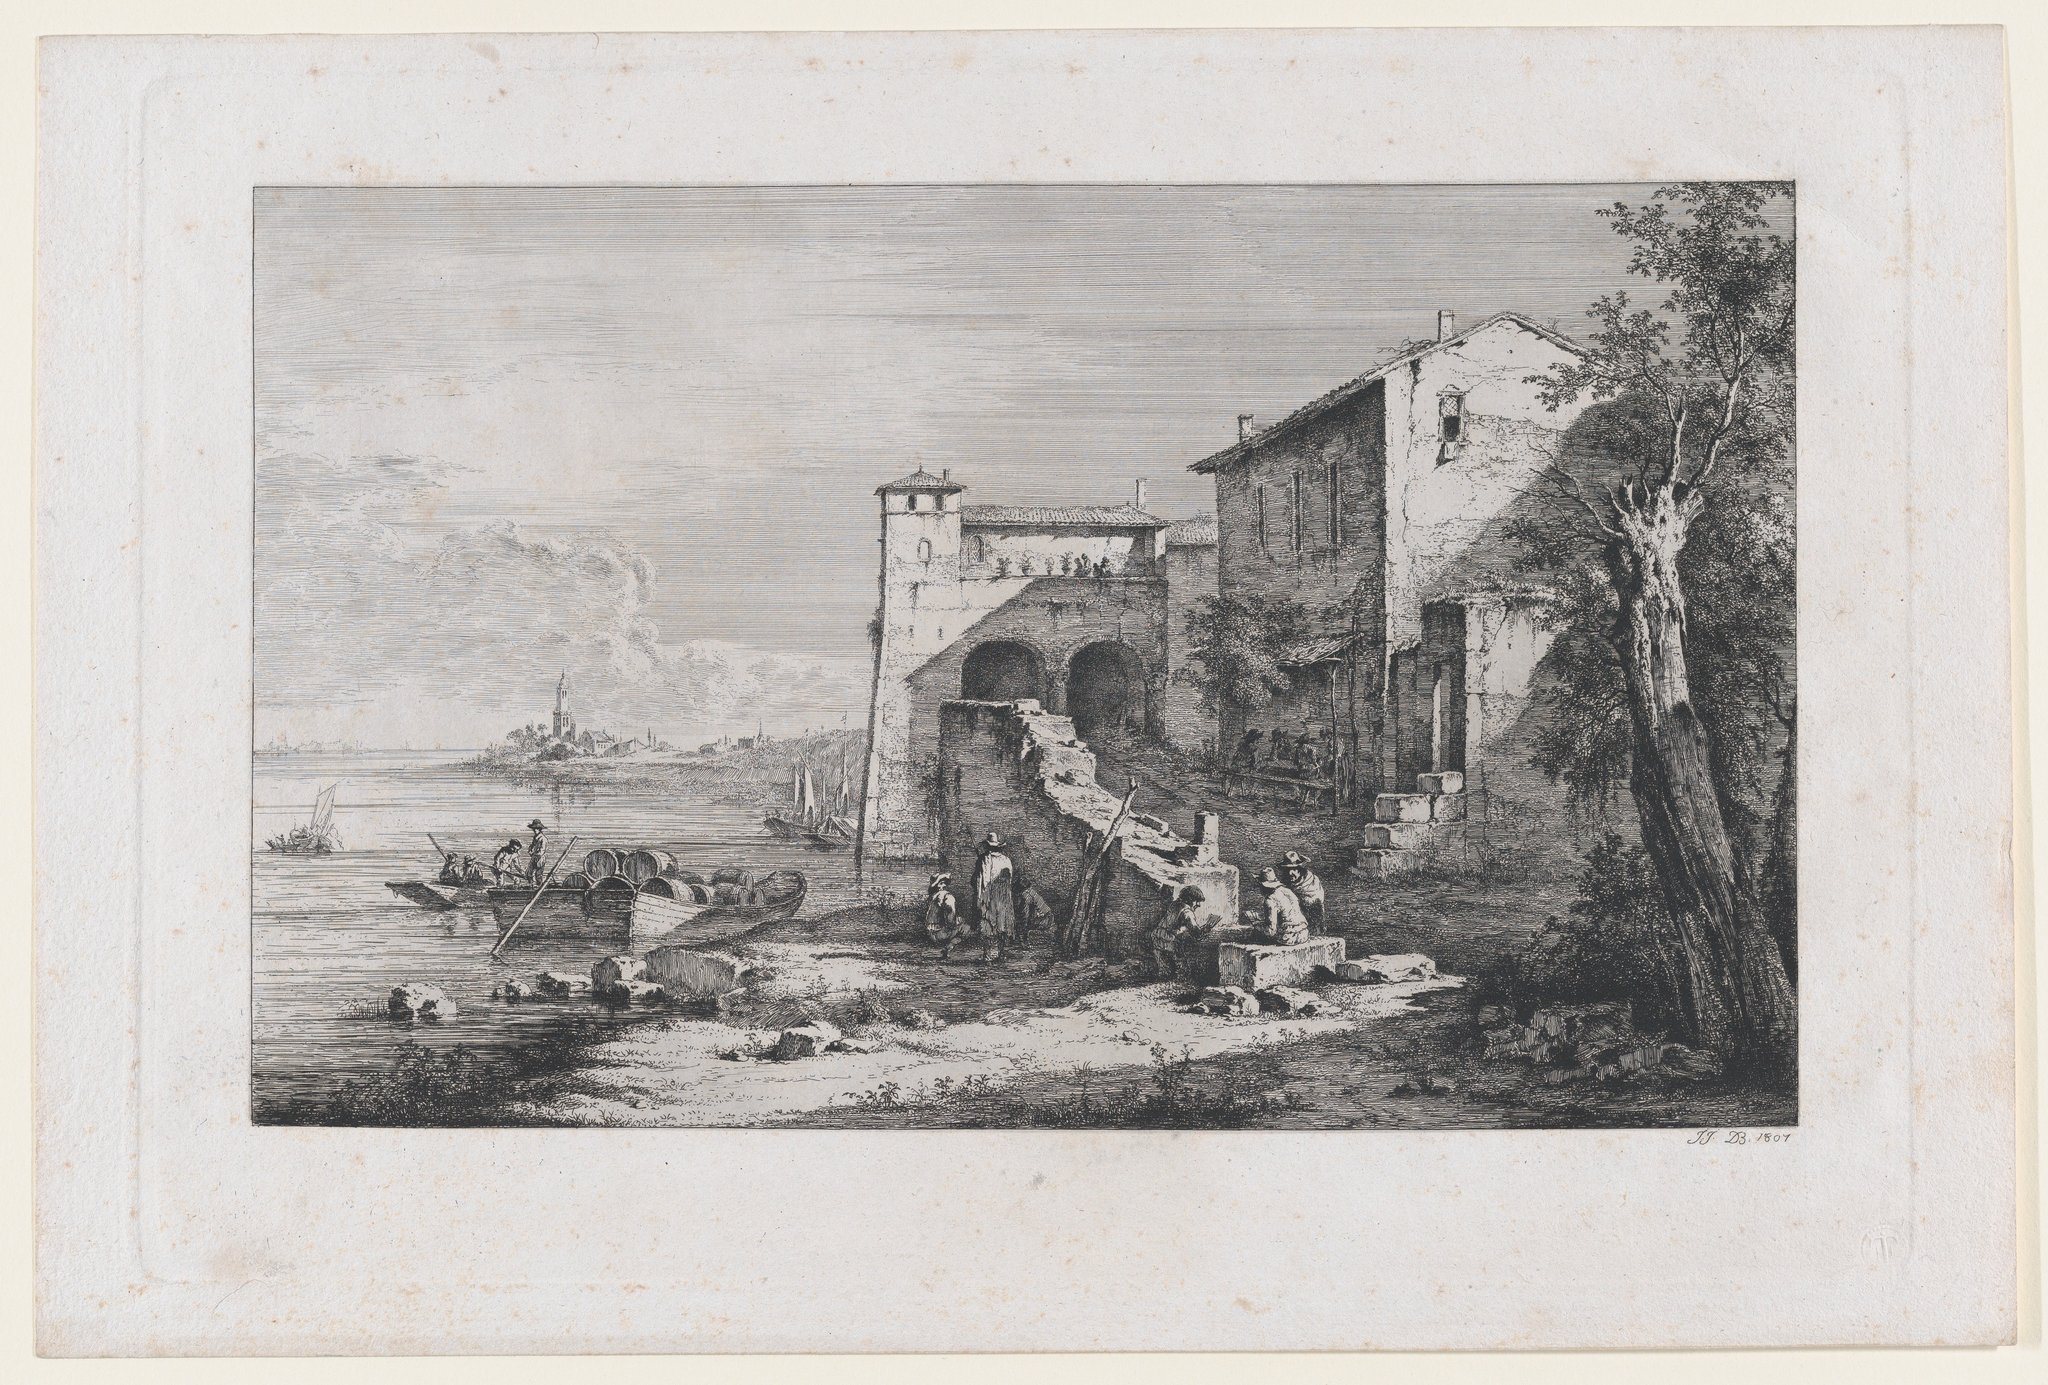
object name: print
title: View of Old Customs House in Rome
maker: jean jacques de boissieu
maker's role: artist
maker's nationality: french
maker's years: 1736-1810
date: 1807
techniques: drypoint, etching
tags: buildings,men,boats,rome